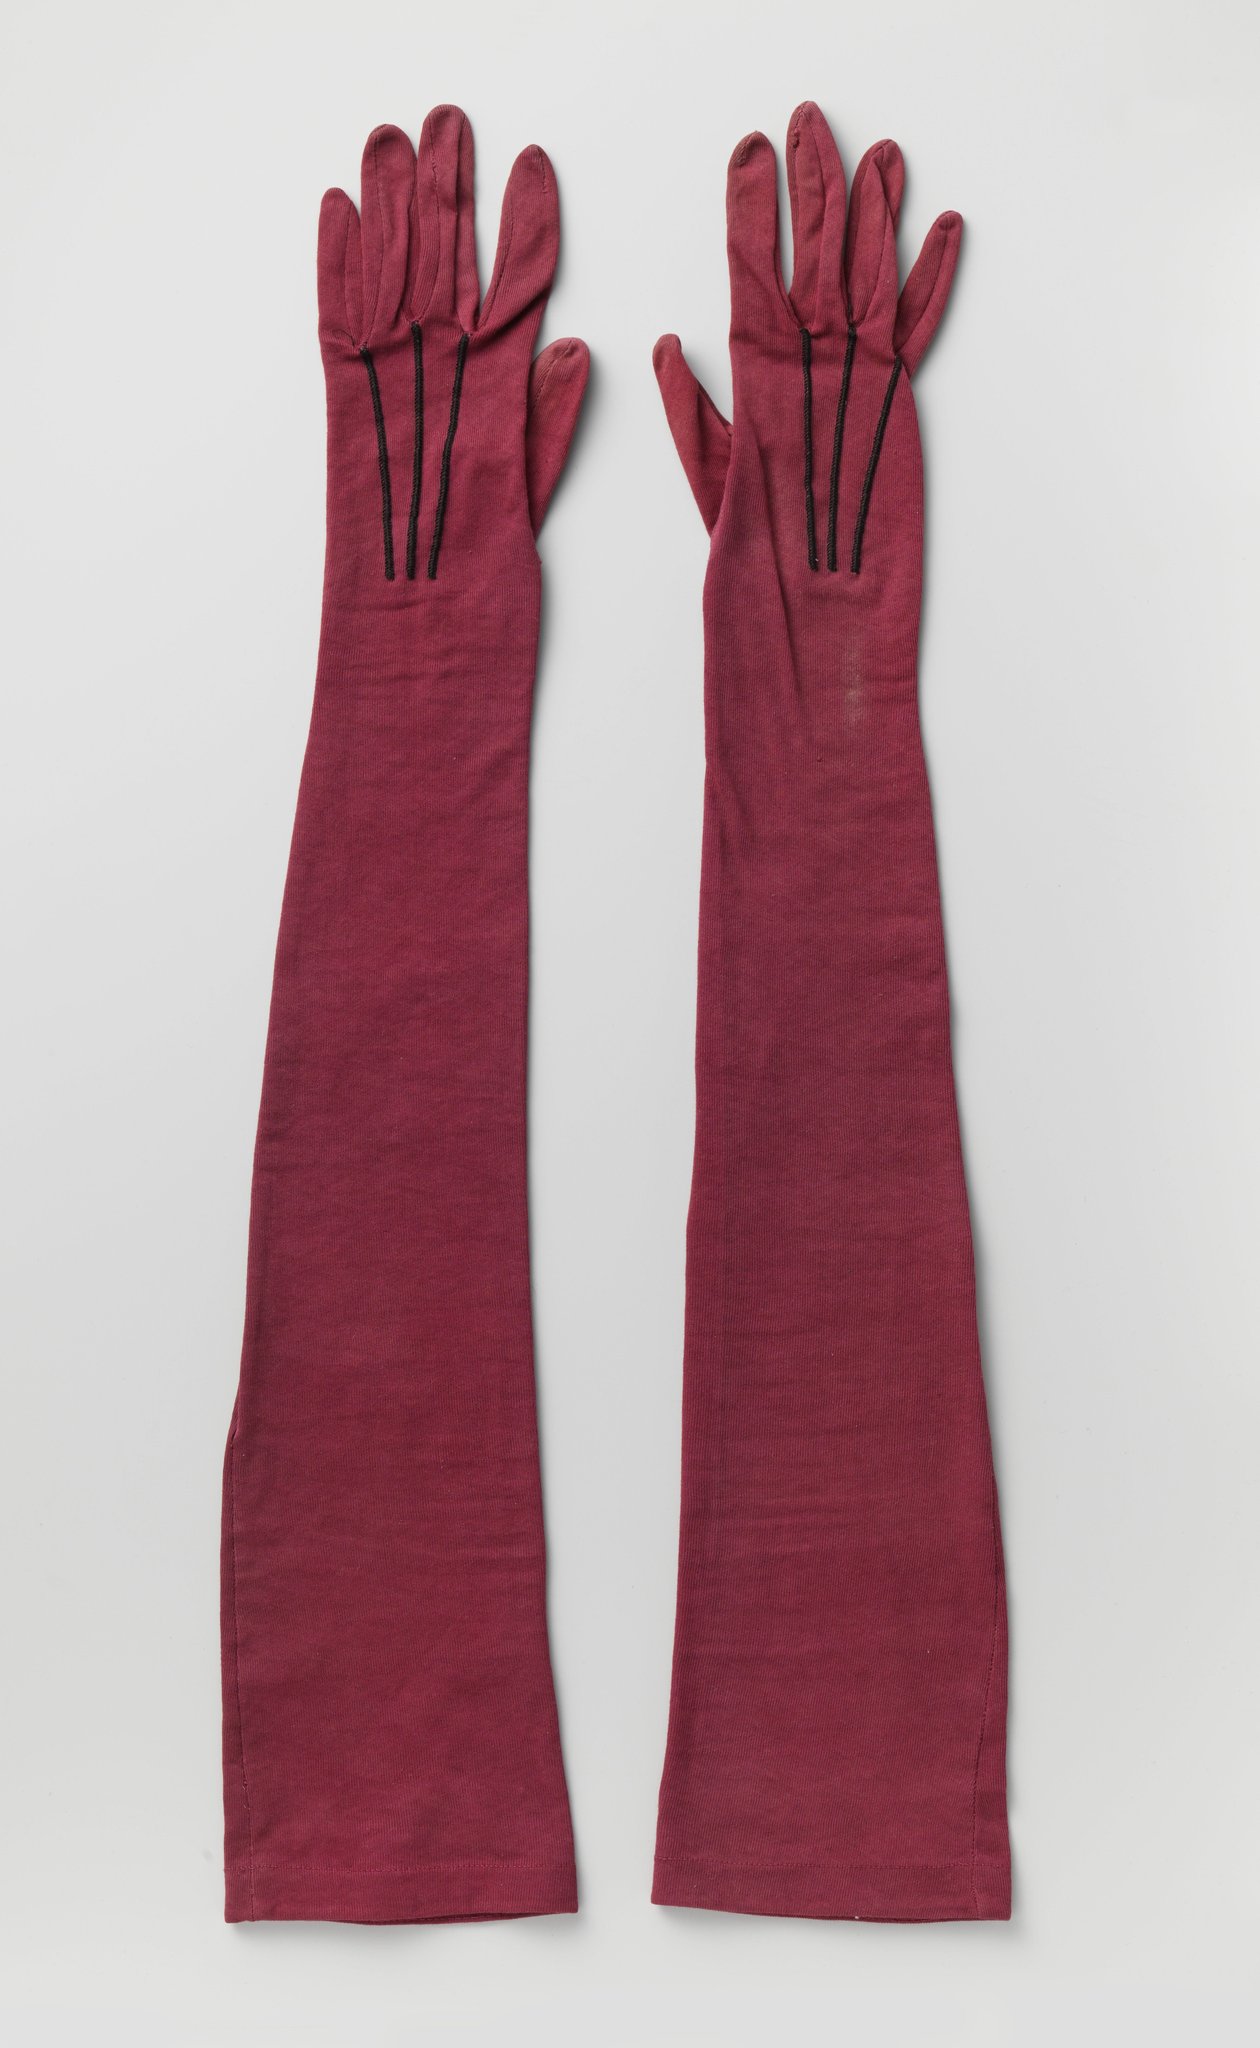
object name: clothing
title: Handschoen van donkerrode katoenen tricot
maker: Anonymous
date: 1895-1900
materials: silk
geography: western europe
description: Linkerhandschoen van donkerrode katoenen tricot, op de rug drie uitstralende zwarte koorden.